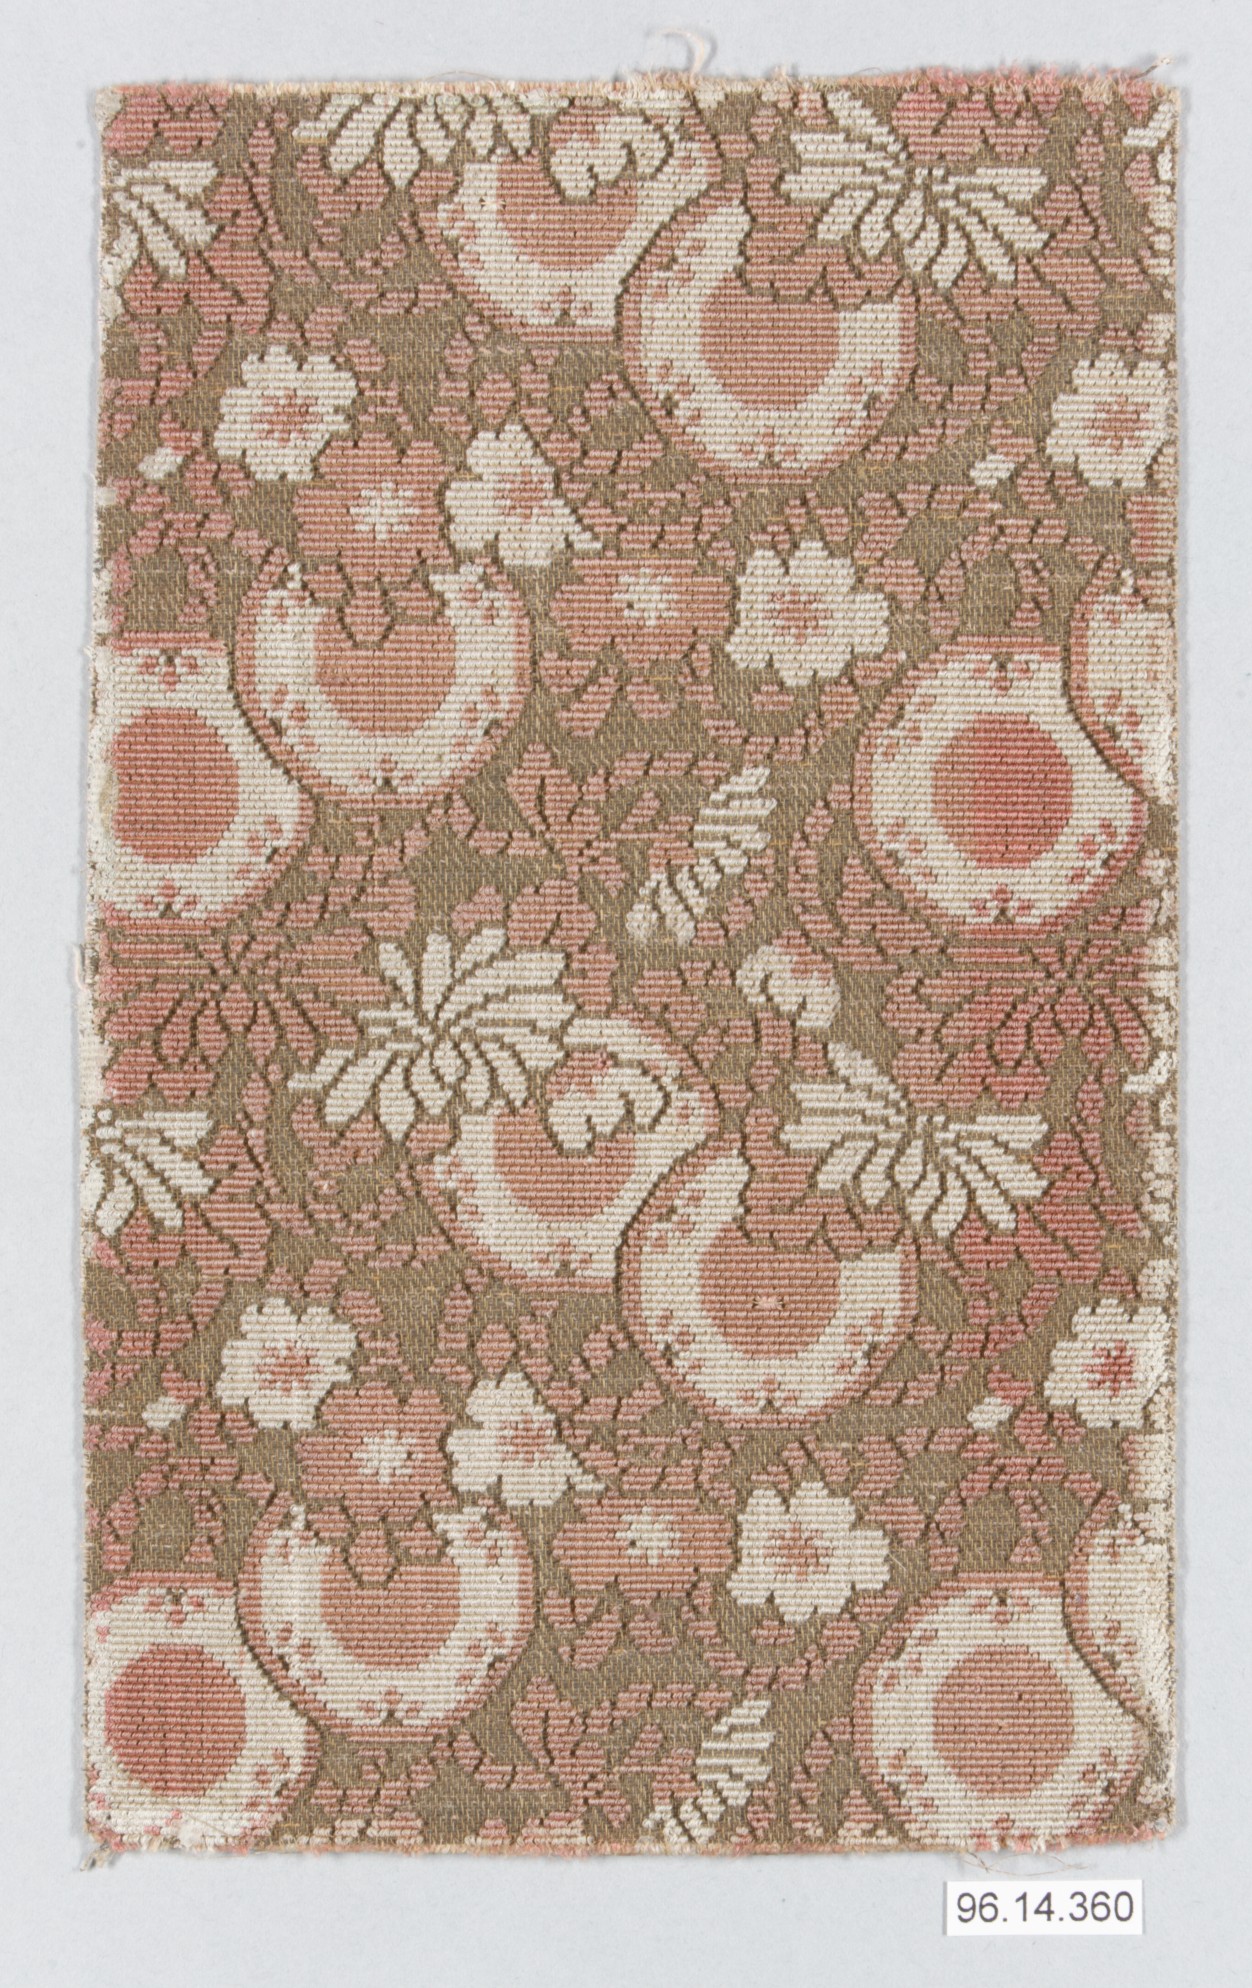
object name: piece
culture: japanese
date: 1801-1900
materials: silk